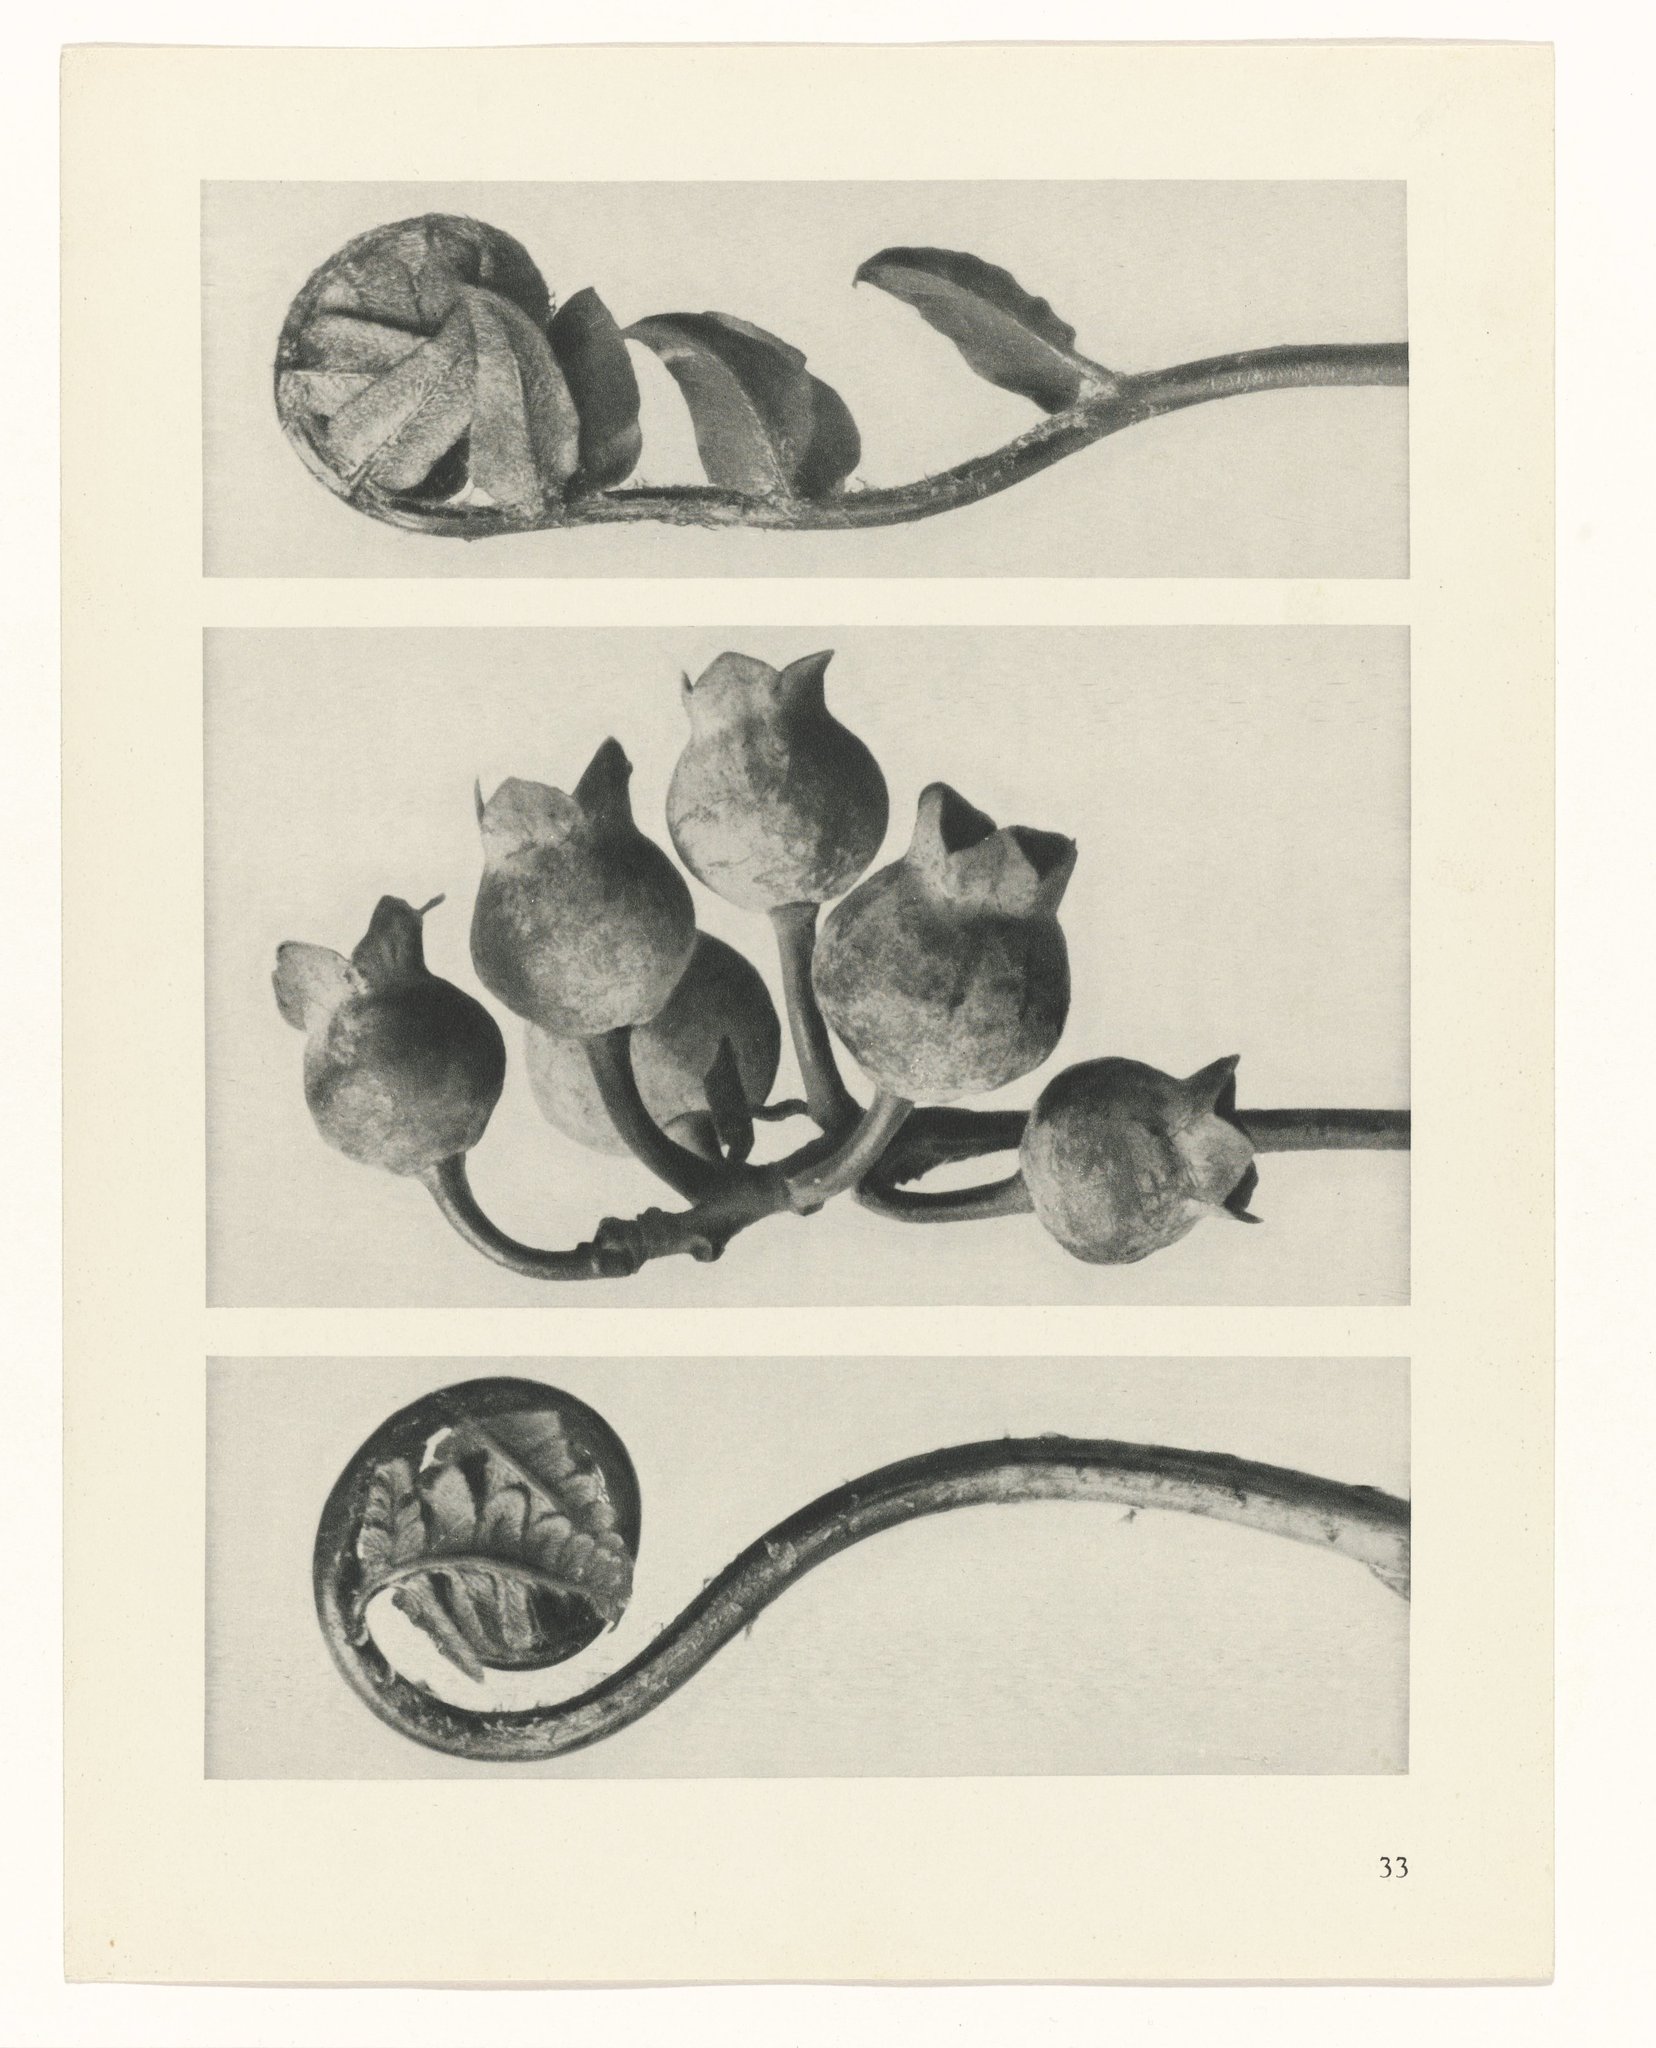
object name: photograph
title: Urformen der Kunst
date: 1928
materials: ink, paper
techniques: rotogravure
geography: berlin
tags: plants (in general)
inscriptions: number: ‘33’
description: facher Vergrößerung. Afkomstig uit losbladige uitgave.